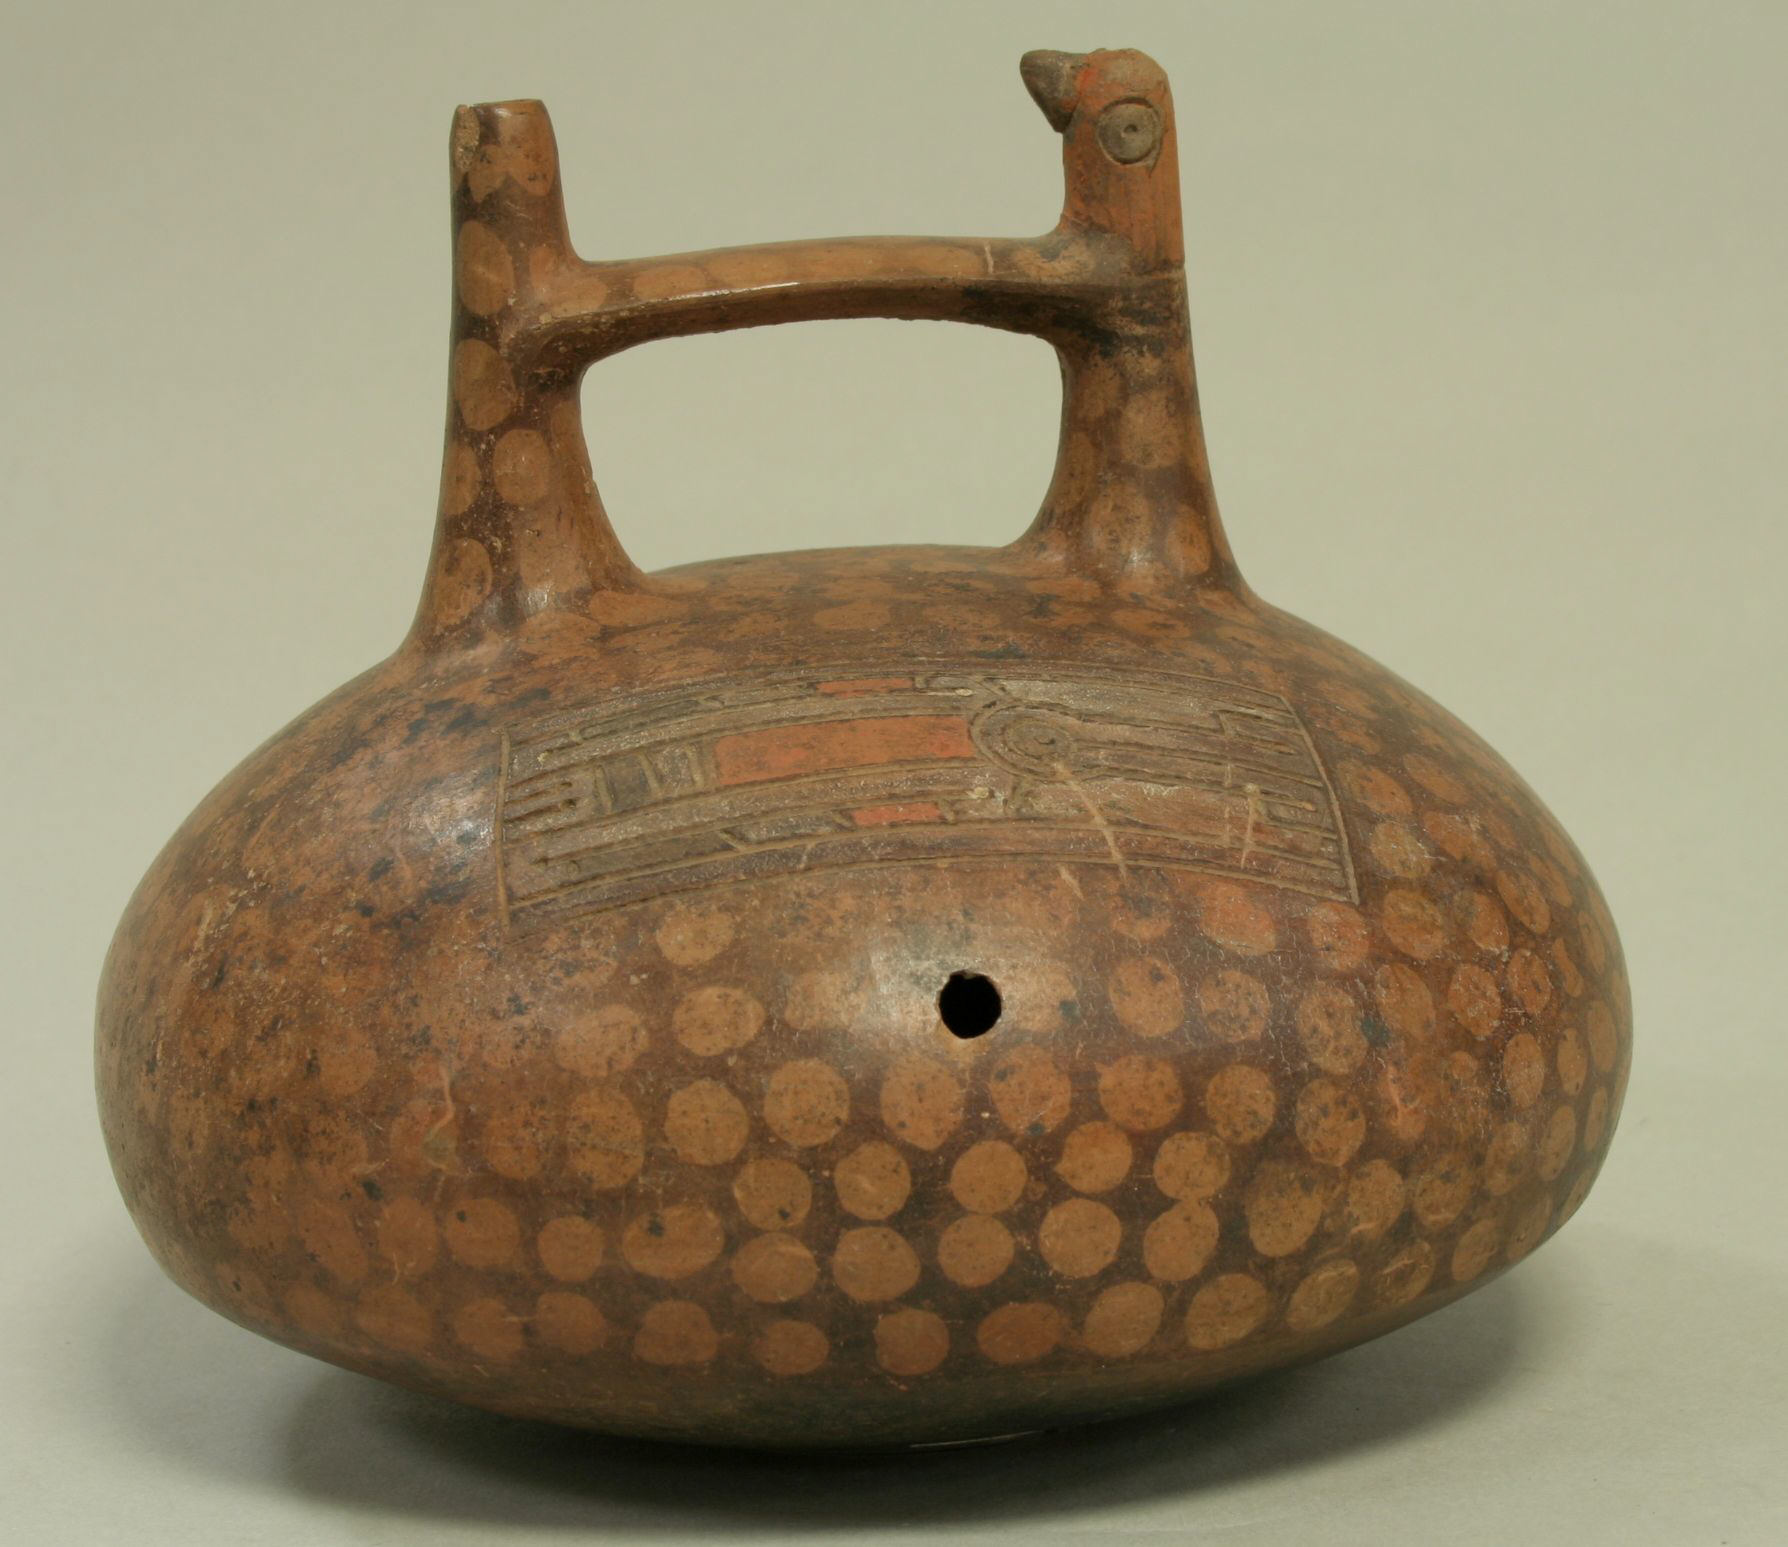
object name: bottle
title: Double Spout and Bridge Bottle with Bird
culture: paracas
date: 500-101 BCE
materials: ceramic, pigment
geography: peru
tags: birds